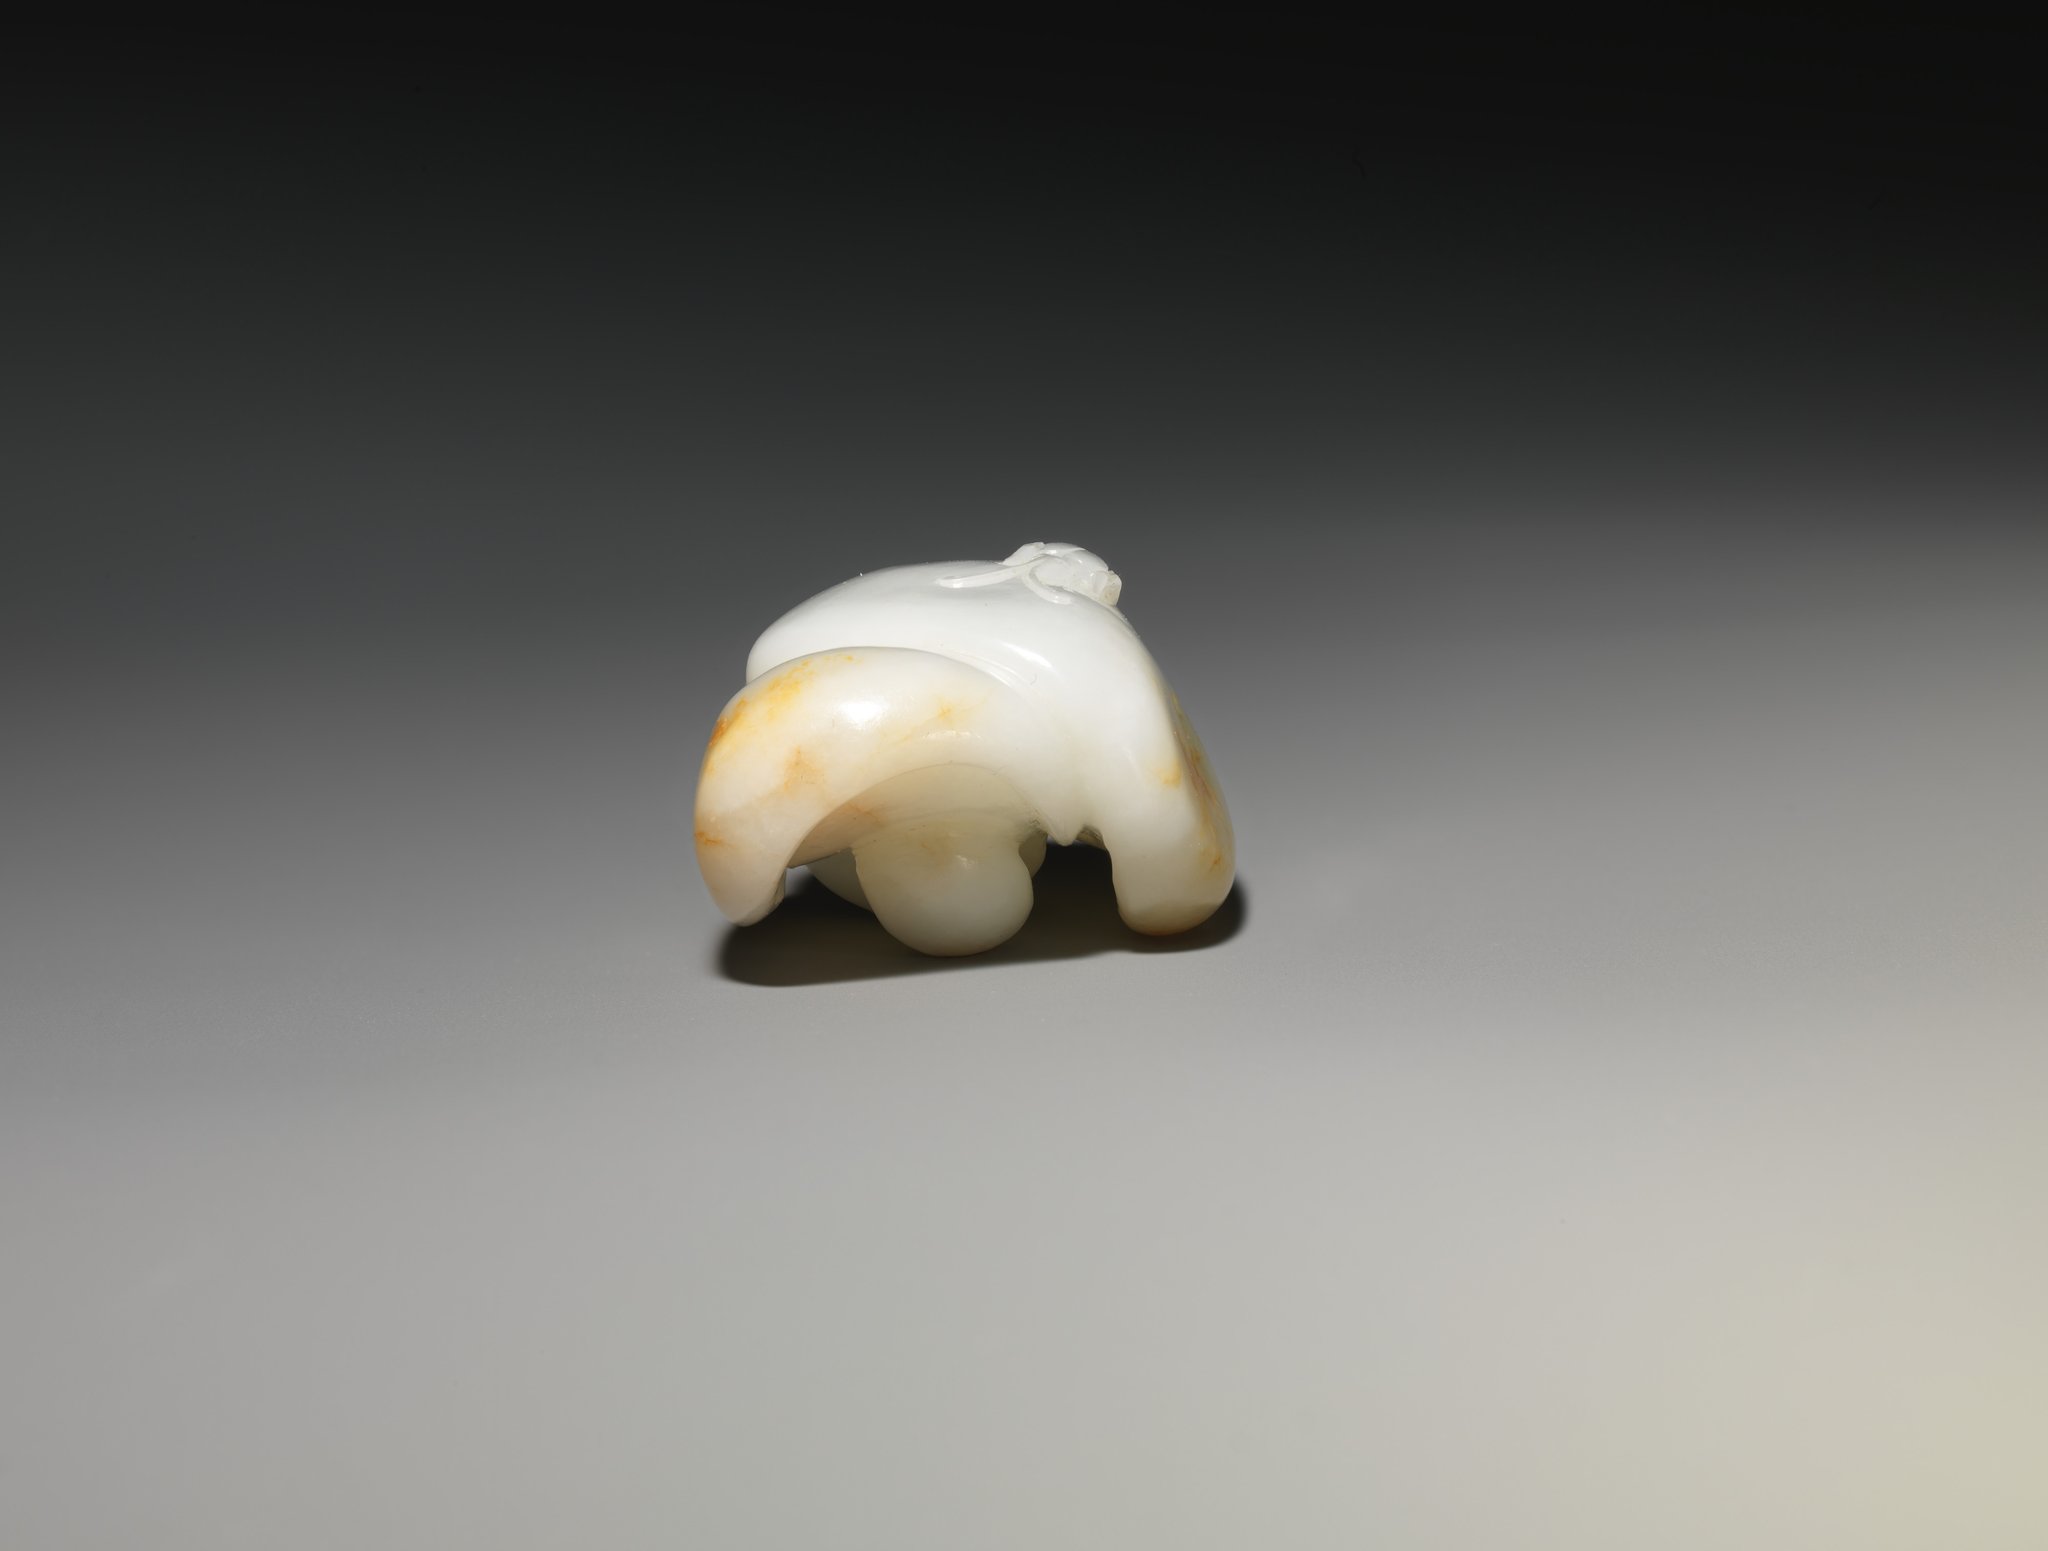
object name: ornament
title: Two mushrooms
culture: chinese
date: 1701-1800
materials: jade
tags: vegetables